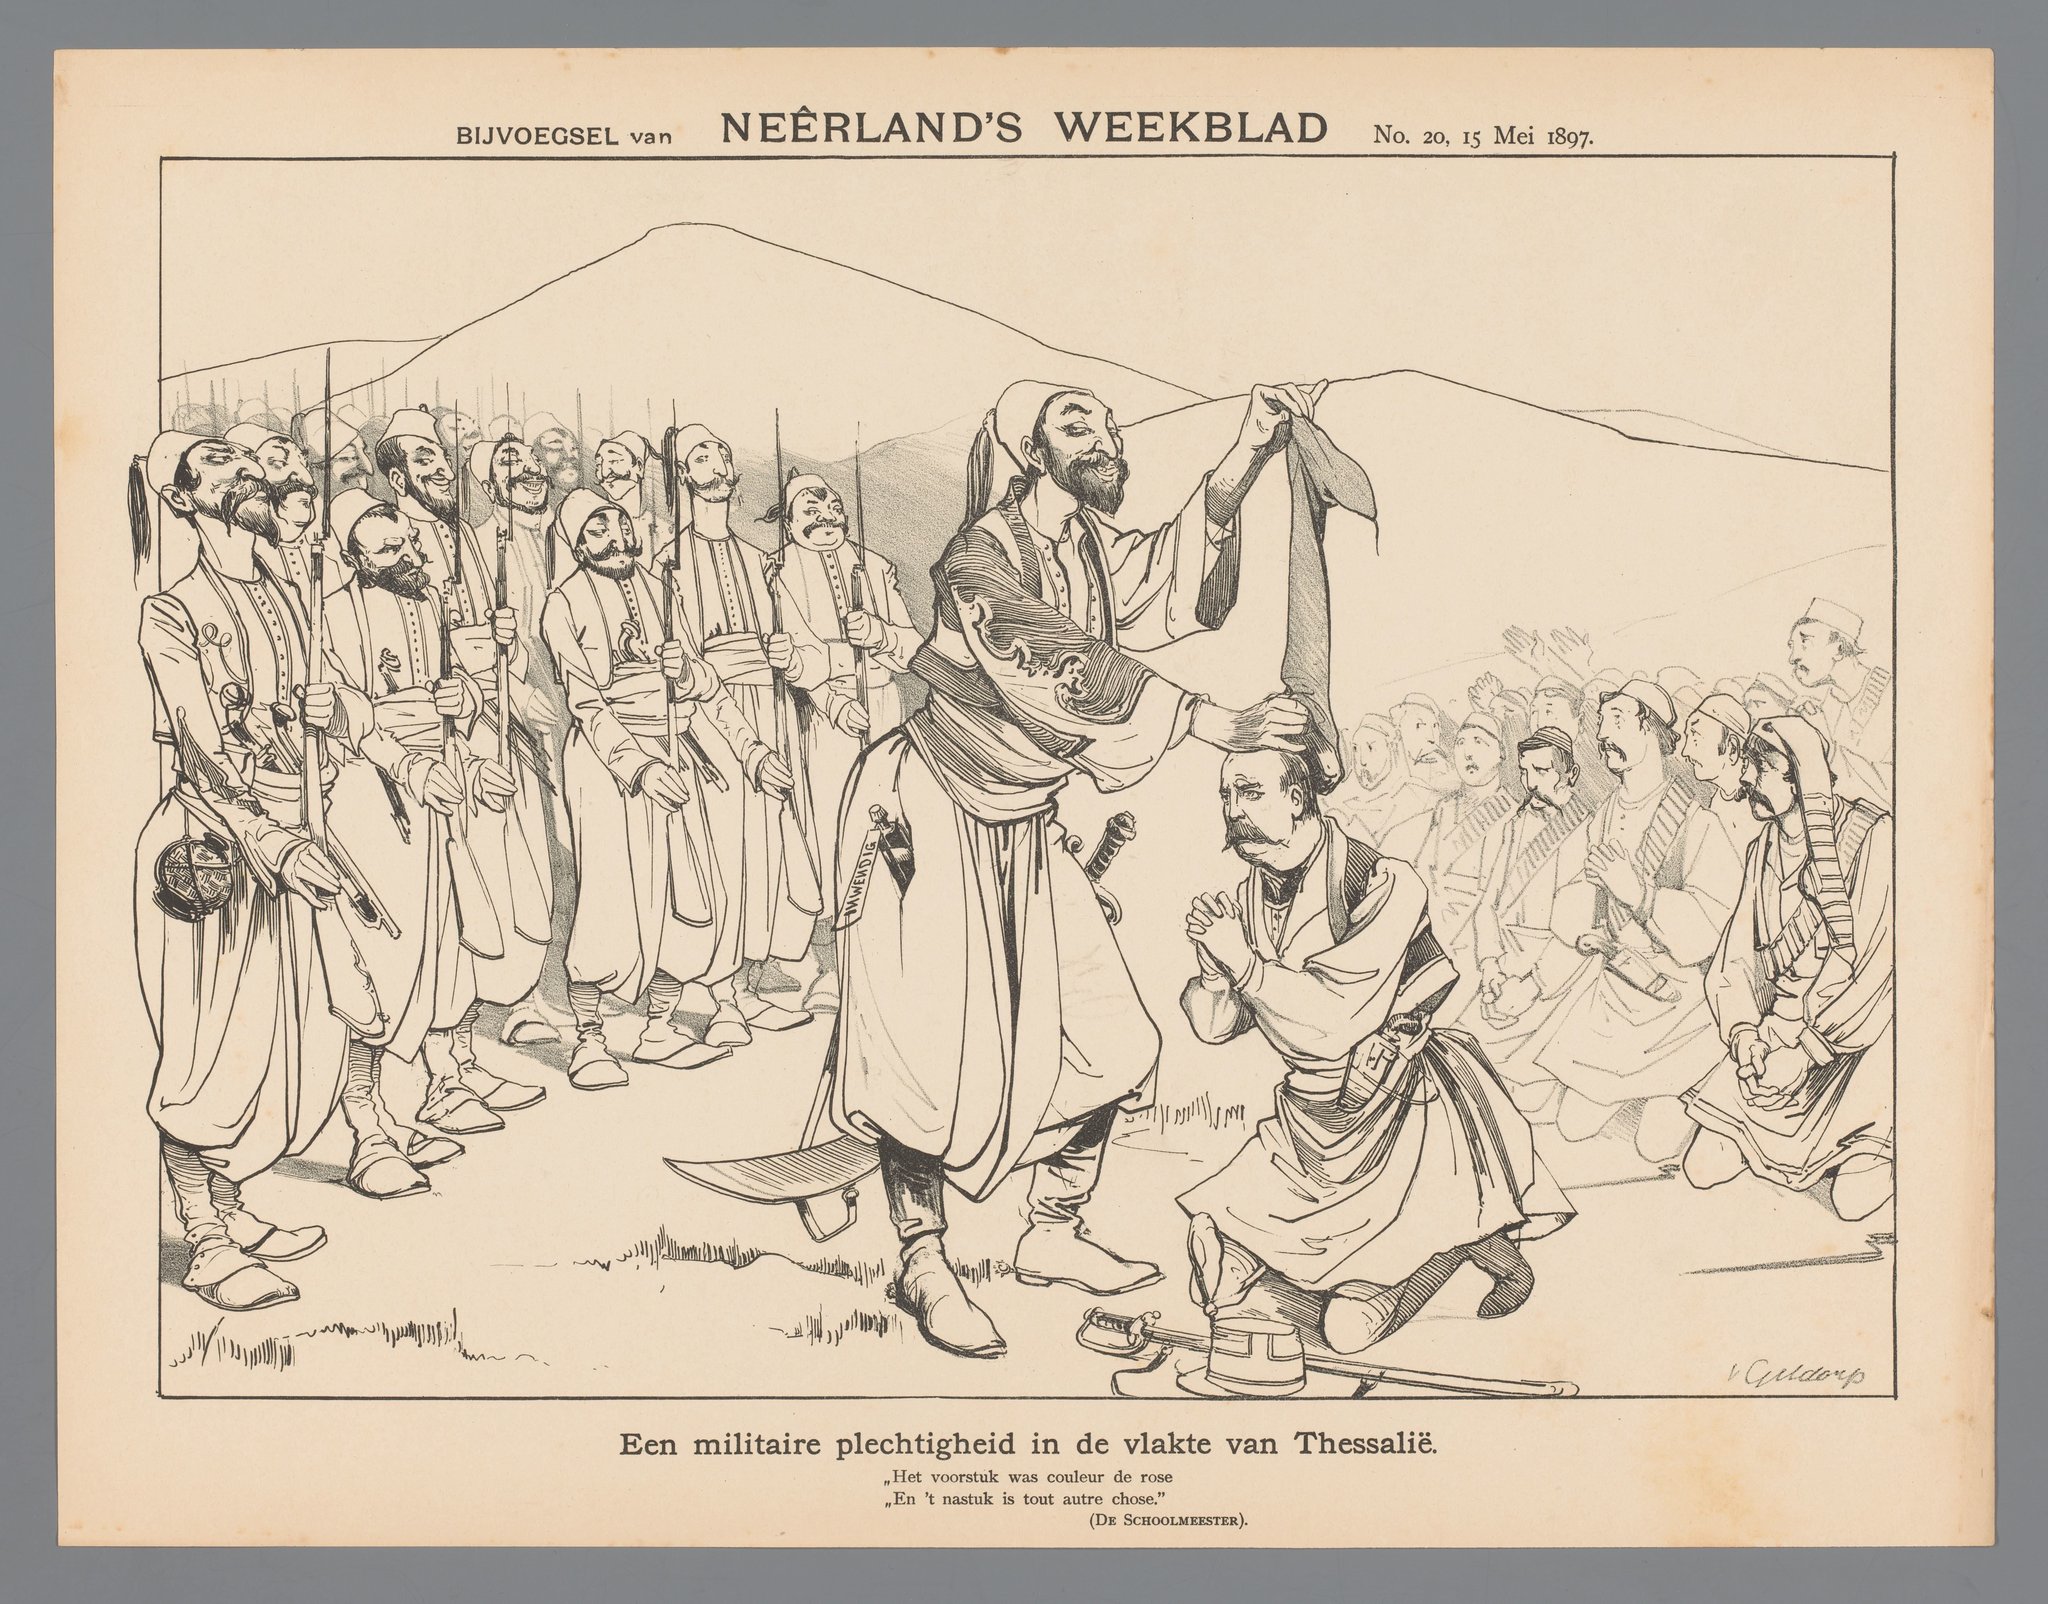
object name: cartoon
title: Een militaire plechtigheid in de vlakte van Thessalië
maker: petrus van geldorp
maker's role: draughtsman, print maker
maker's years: 1872-1939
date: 1897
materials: paper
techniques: lithograph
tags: copenhagen (city), warfare; military affairs, political caricatures and satires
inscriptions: date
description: Prent uit het bijvoegsel van: Neêrland’s Weekblad, nr. 20, 15 mei 1897.